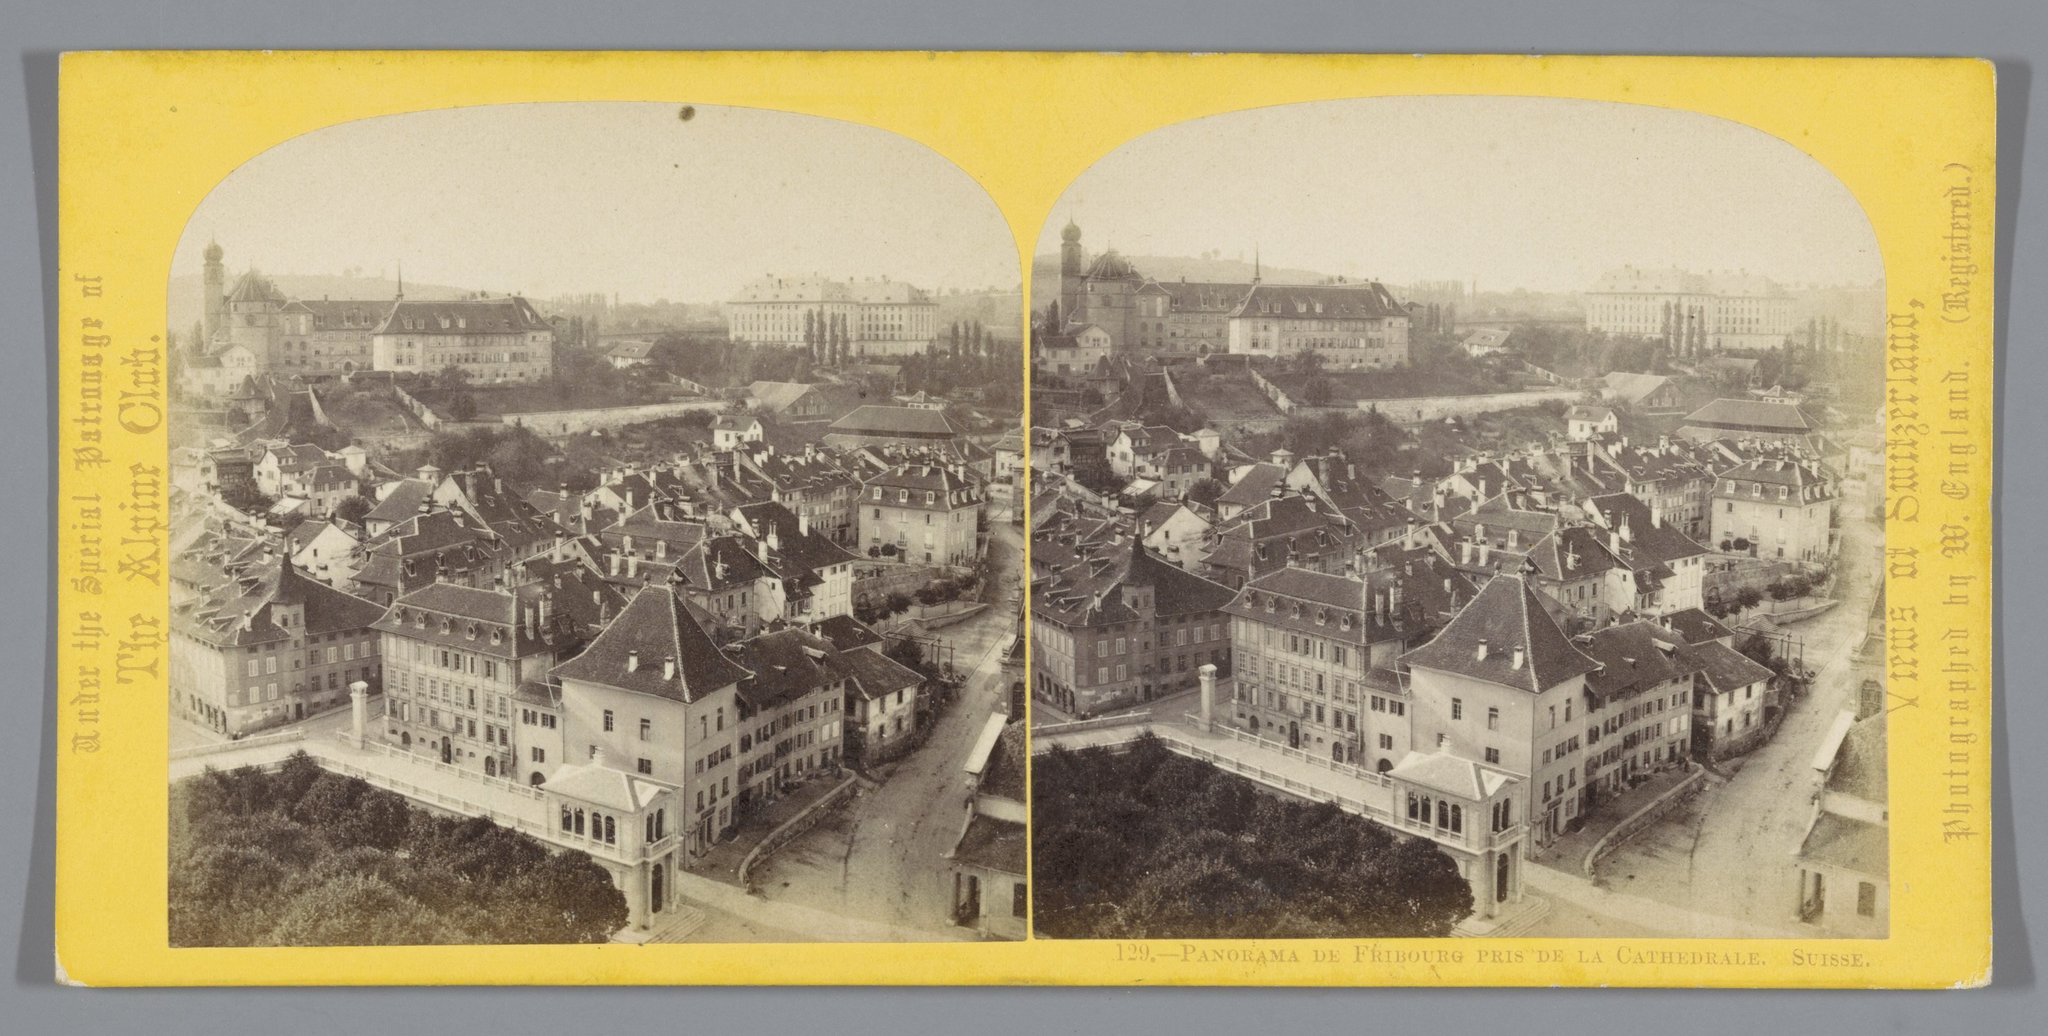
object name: stereograph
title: Gezicht op Fribourg, gezien vanaf de Kathedraal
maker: william england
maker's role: fotograaf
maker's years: 1816-1896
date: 1850-1880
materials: cardboard, photographic support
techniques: albumen print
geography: fribourg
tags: city-view in general; 'veduta'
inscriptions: number: ‘129.’, inscription: ‘Views of Switzerland, photographed by W. England. (Registered) Under the Special Patronage of the Alpine Club.’